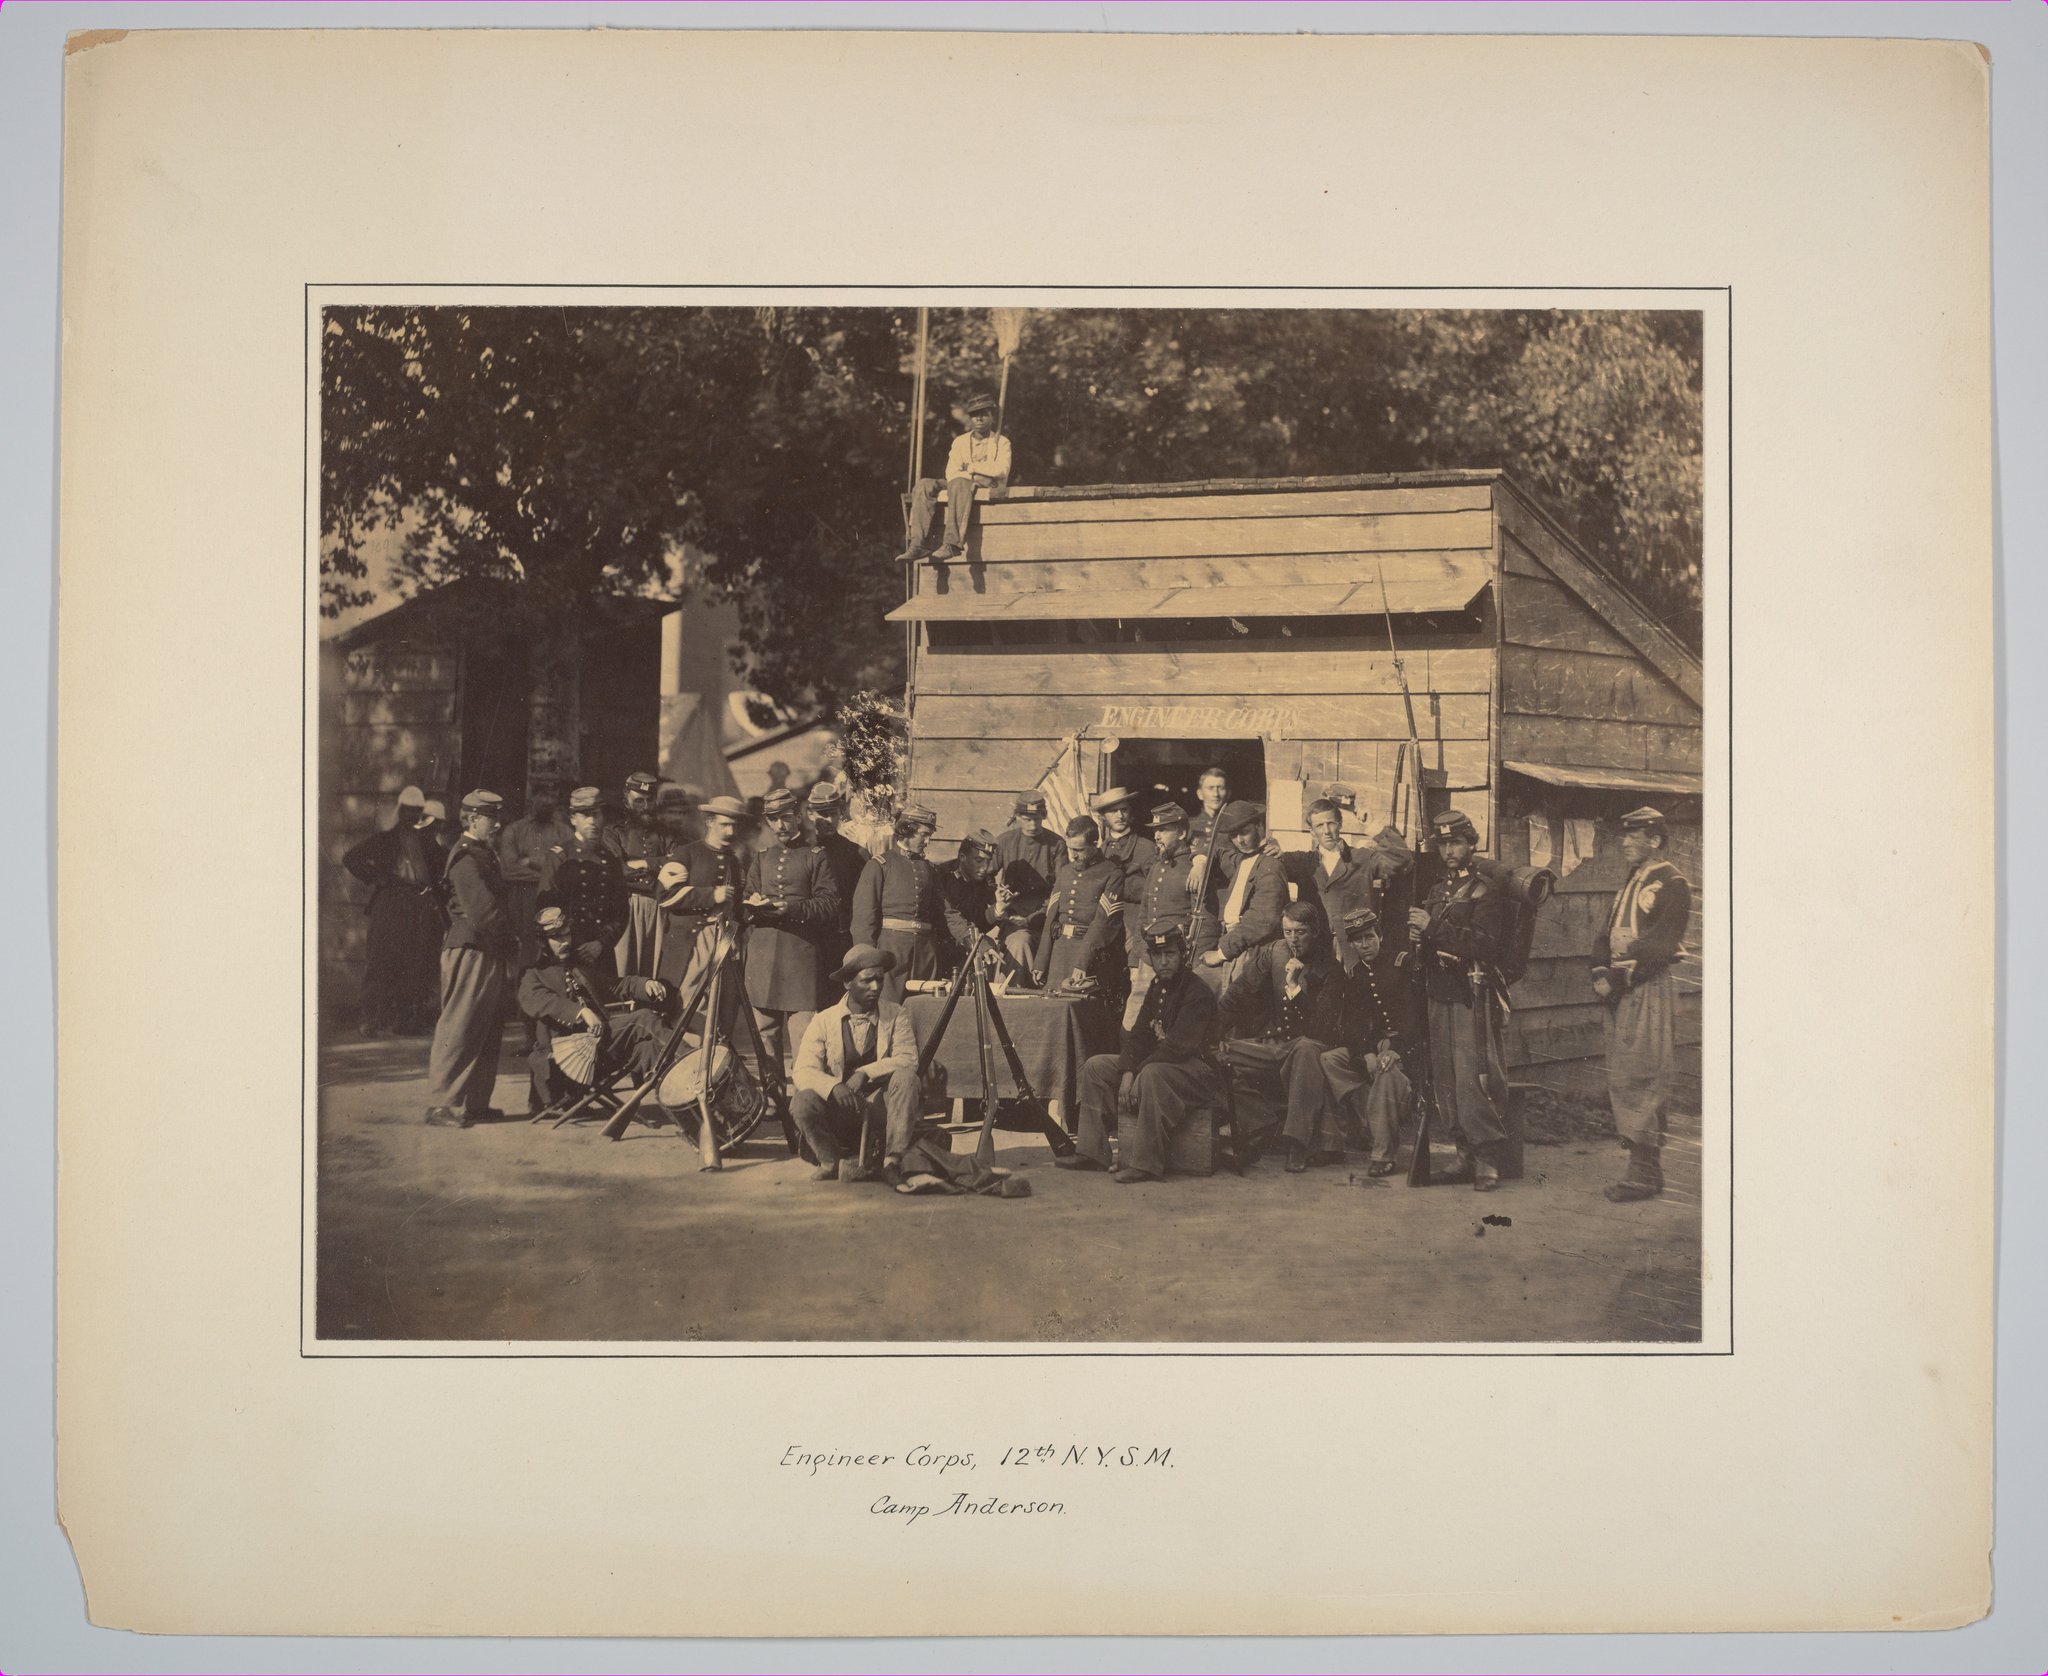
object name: photograph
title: Engineers Corps, 12th New York State Militia, Camp Anderson, Washington, D.C.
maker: mathew b. brady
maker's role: artist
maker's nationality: american, born ireland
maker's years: 1823-1896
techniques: albumen silver print, glass negative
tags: american civil war